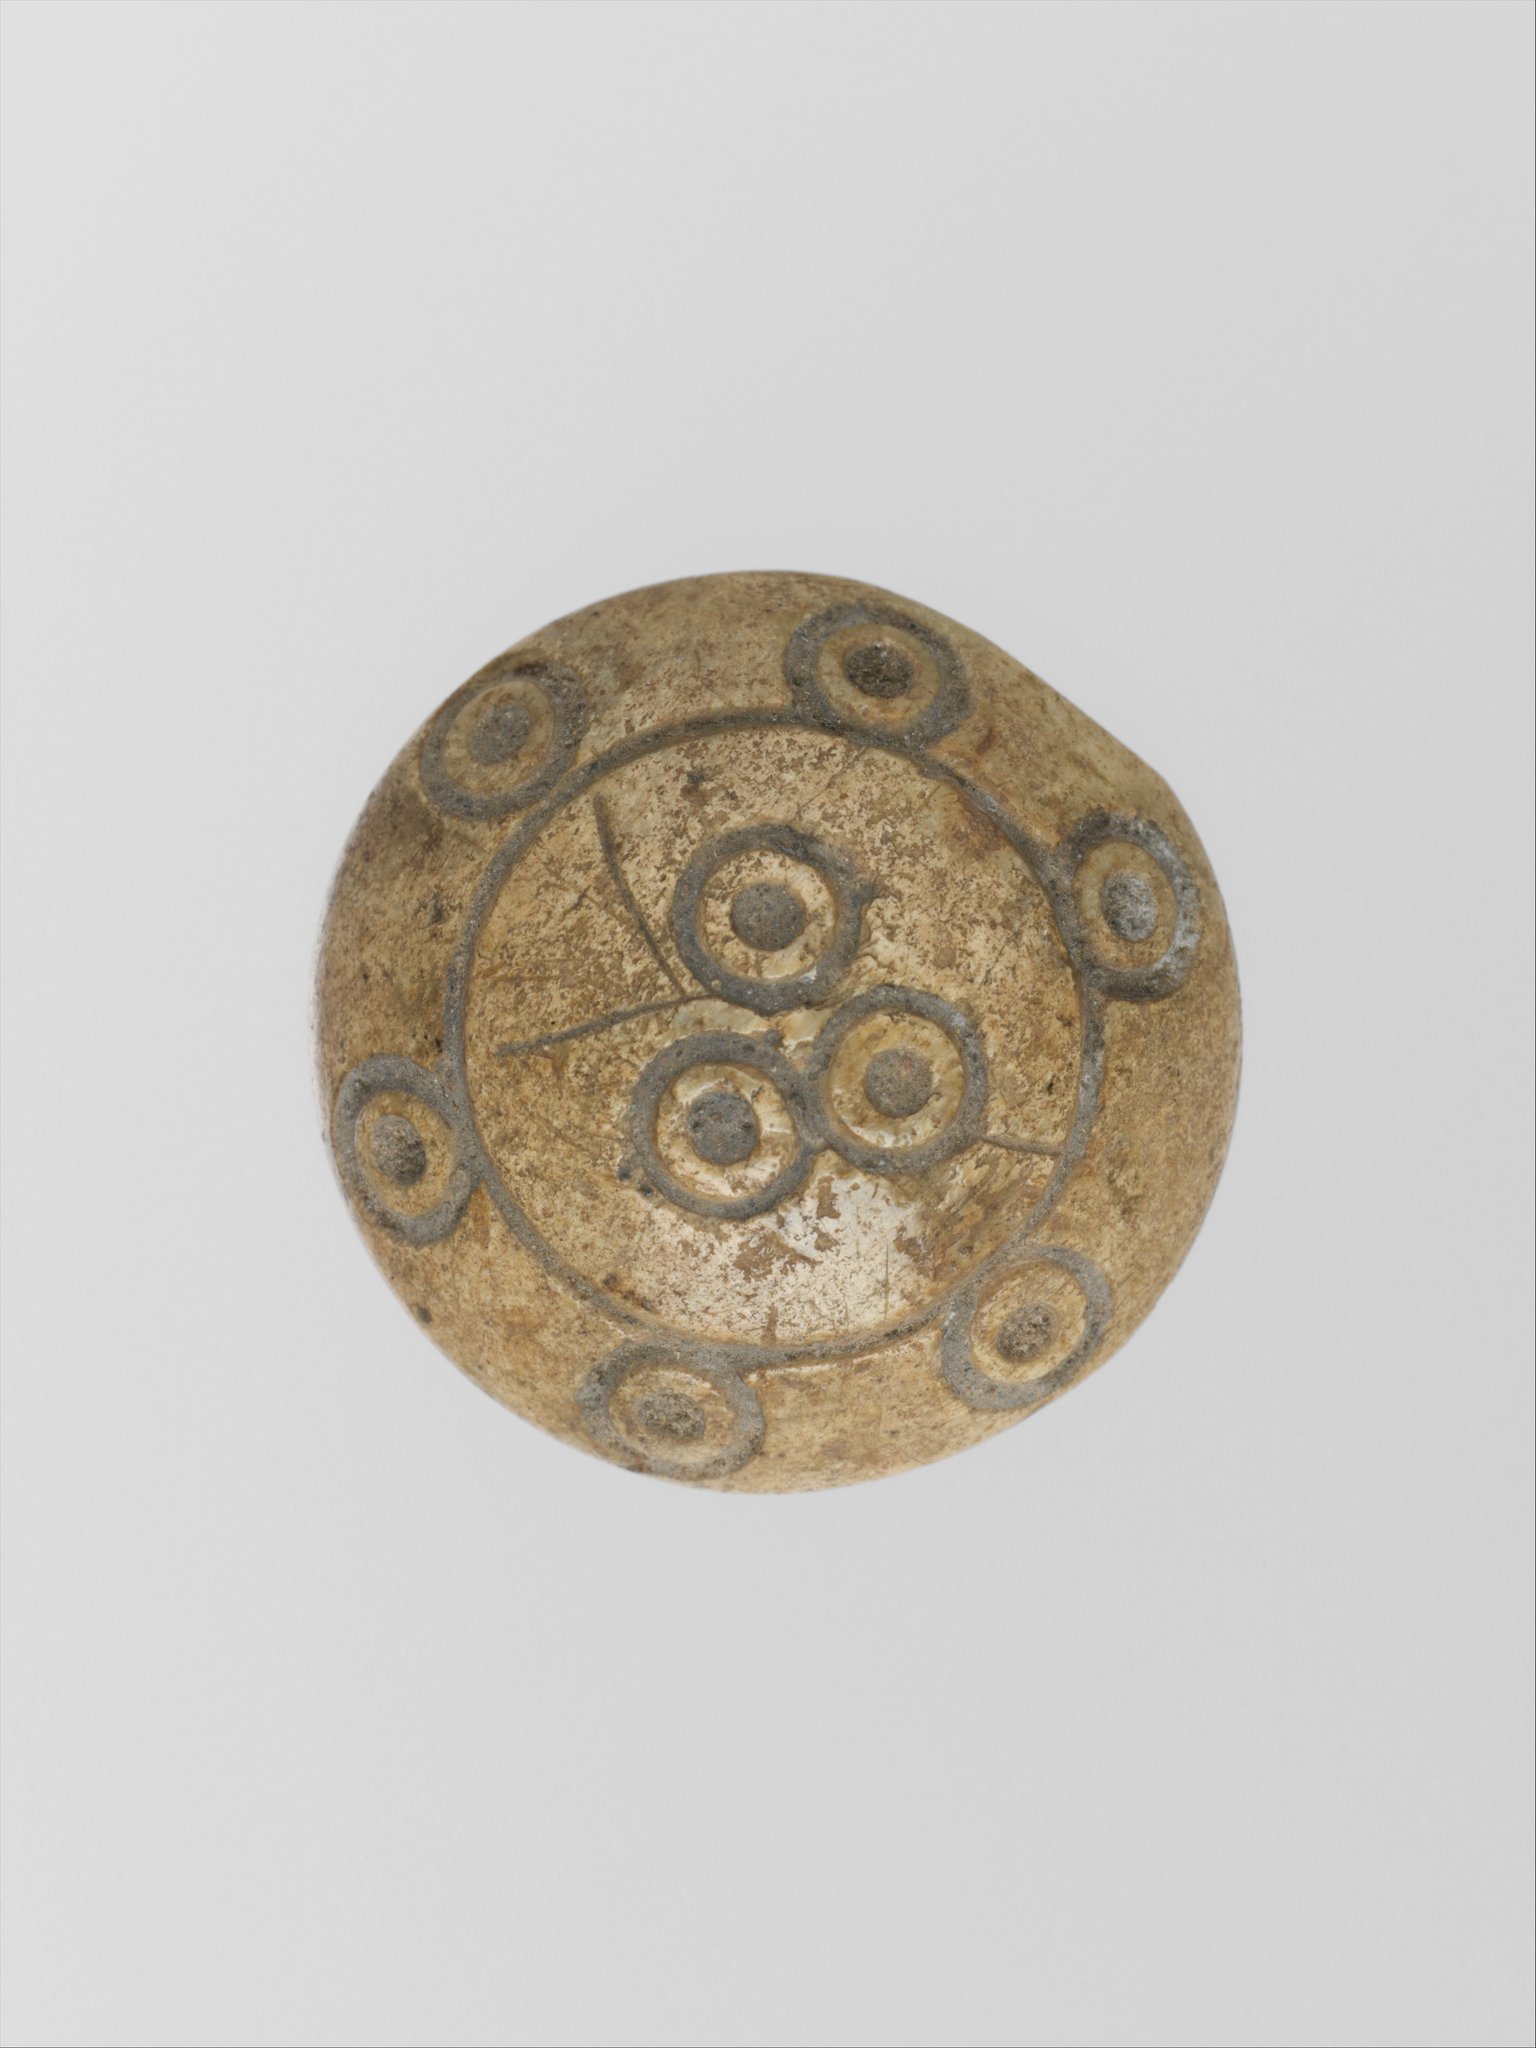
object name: disk or button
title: Bone counter or gaming piece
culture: roman or later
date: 301-400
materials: bone, ivory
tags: games